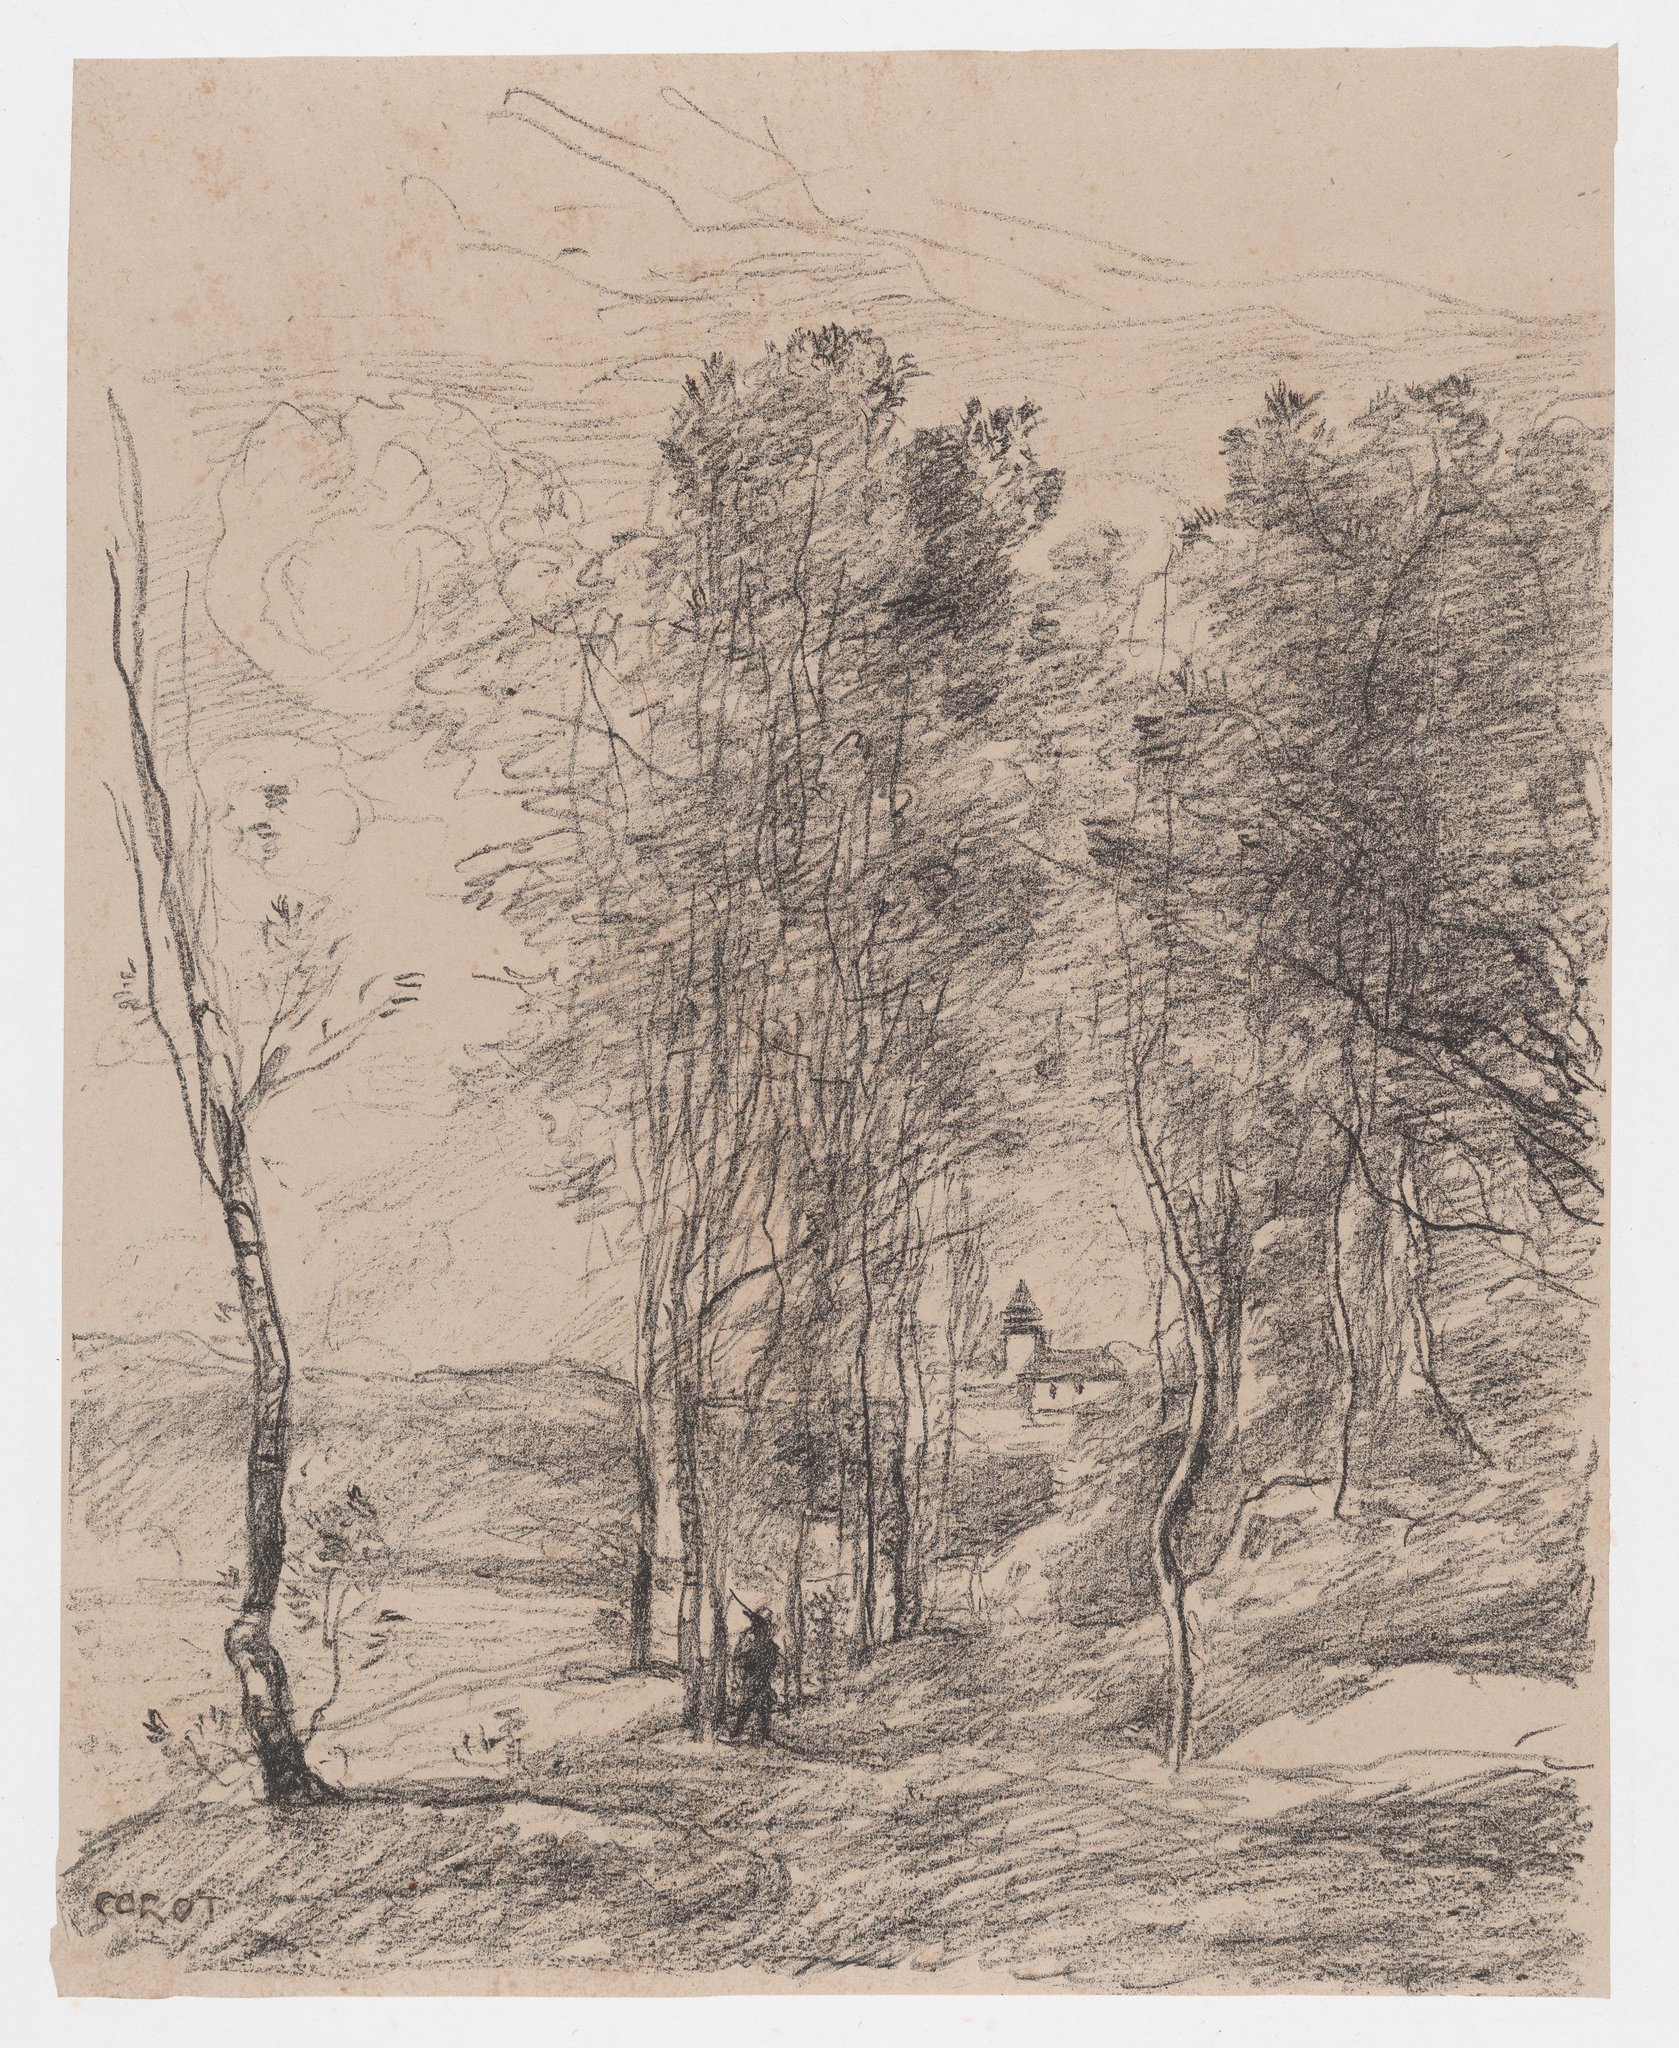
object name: print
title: The Belfry of St.-Nicolas-les-Arras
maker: jean-baptiste-camille corot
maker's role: artist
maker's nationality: french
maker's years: 1796-1875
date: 1871-1872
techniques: lithograph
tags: human figures,trees